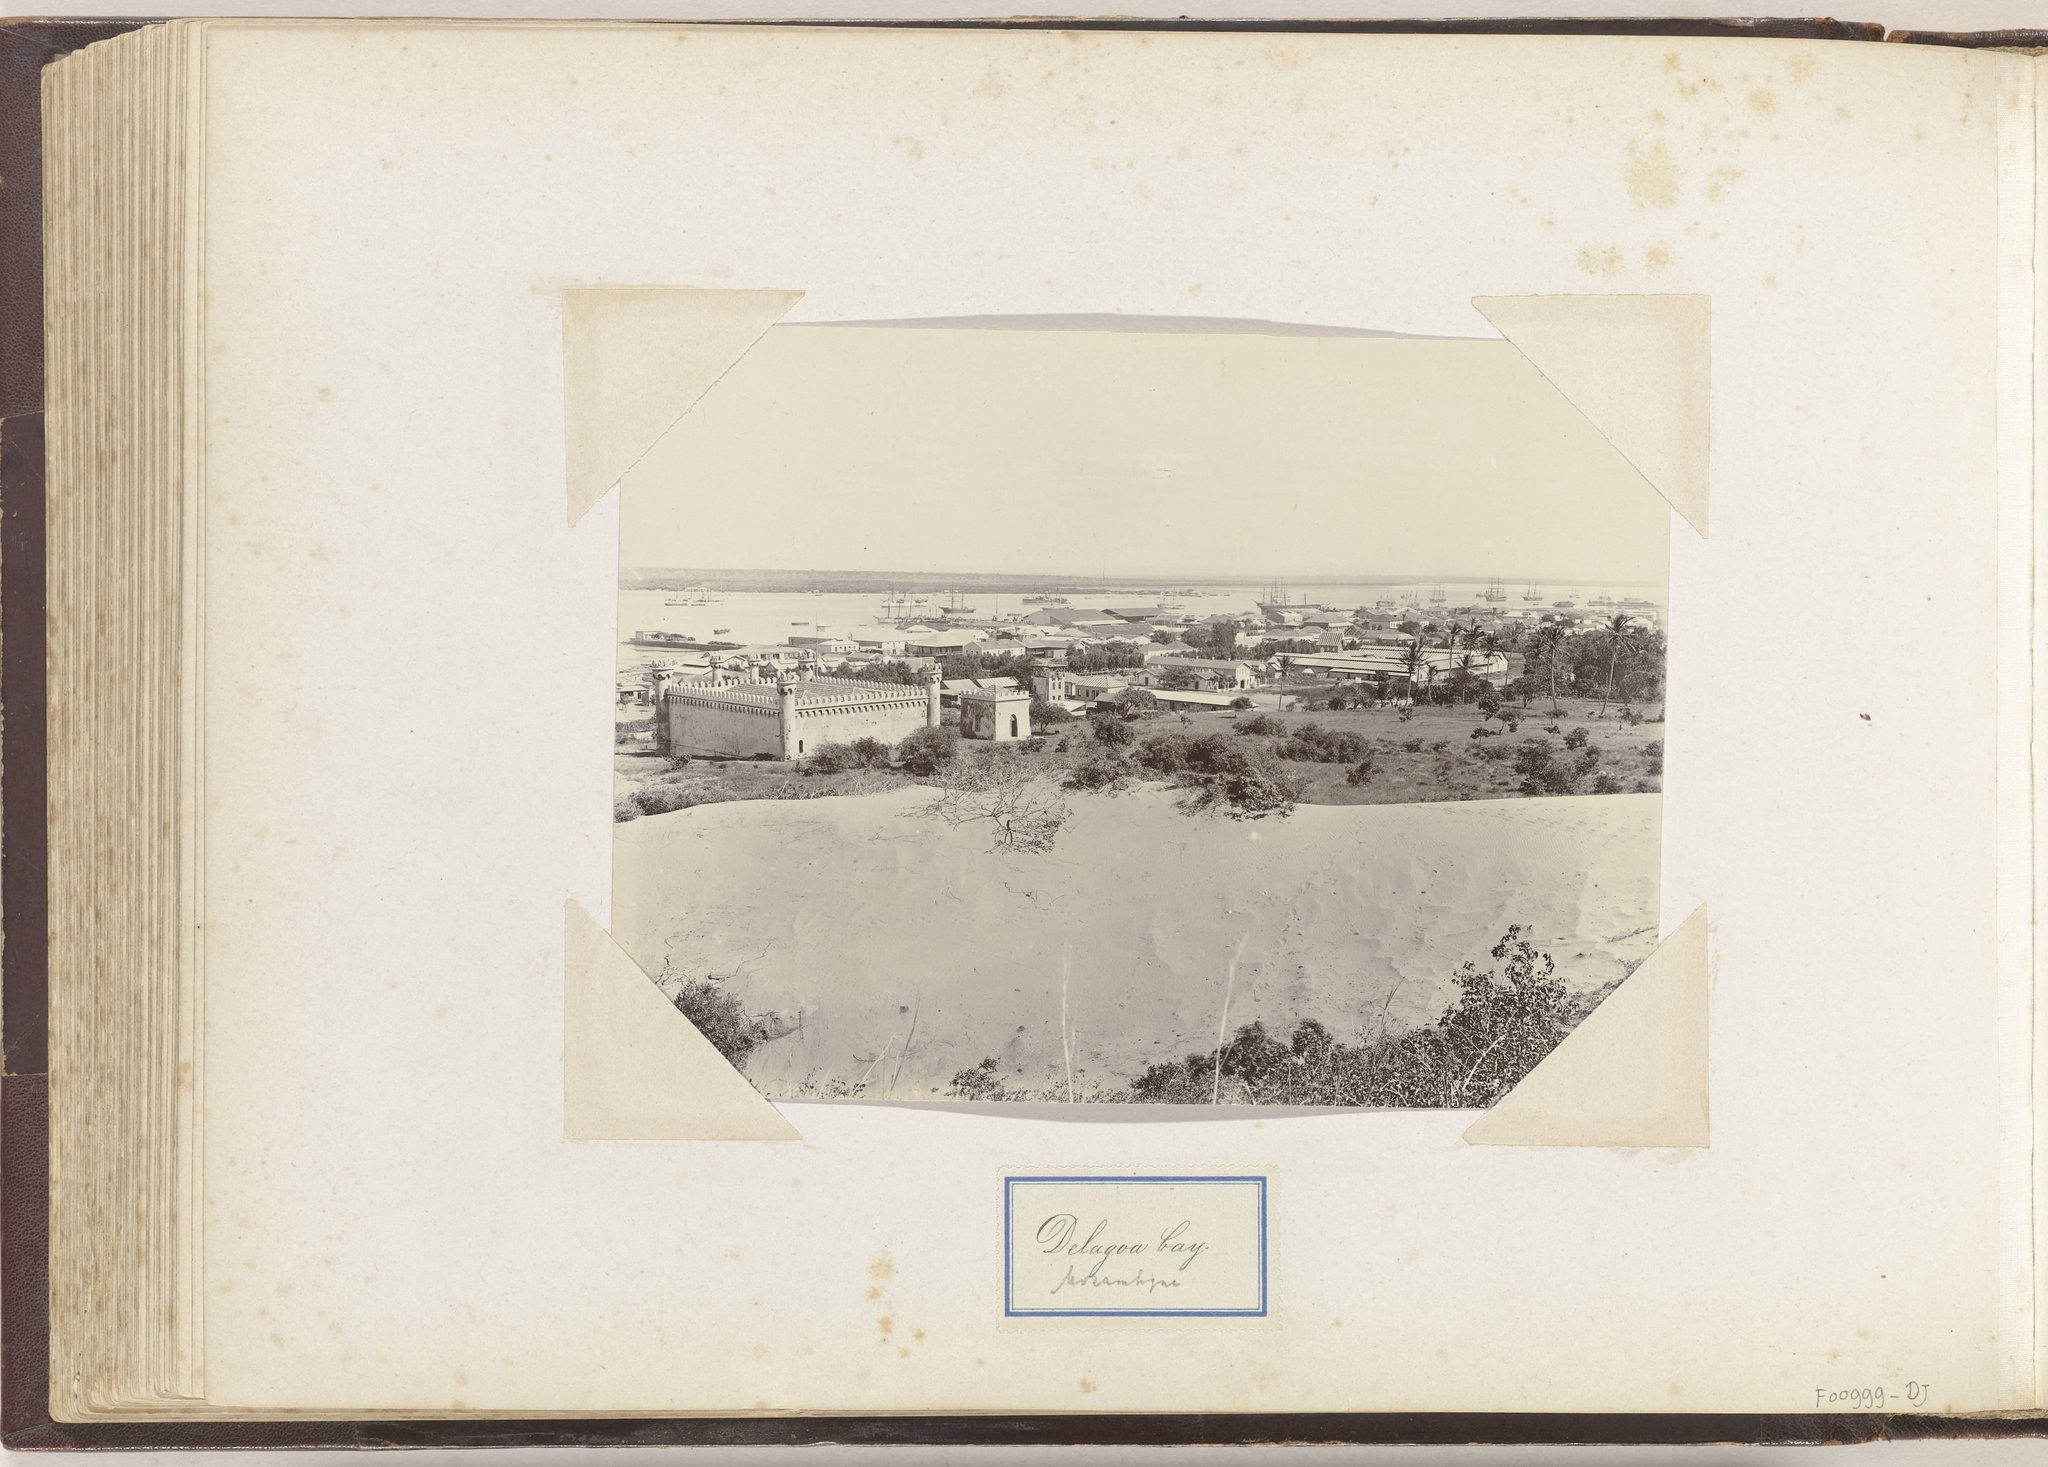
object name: photograph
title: Gezicht op Delagoa Bay in Mozambique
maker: Anonymous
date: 1900-1920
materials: paper, photographic support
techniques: gelatin silver print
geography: maputo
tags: prospect of city, town panorama, silhouette of city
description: Onderdeel van Album met 191 foto's van een reis naar en door Zuid-Afrika.